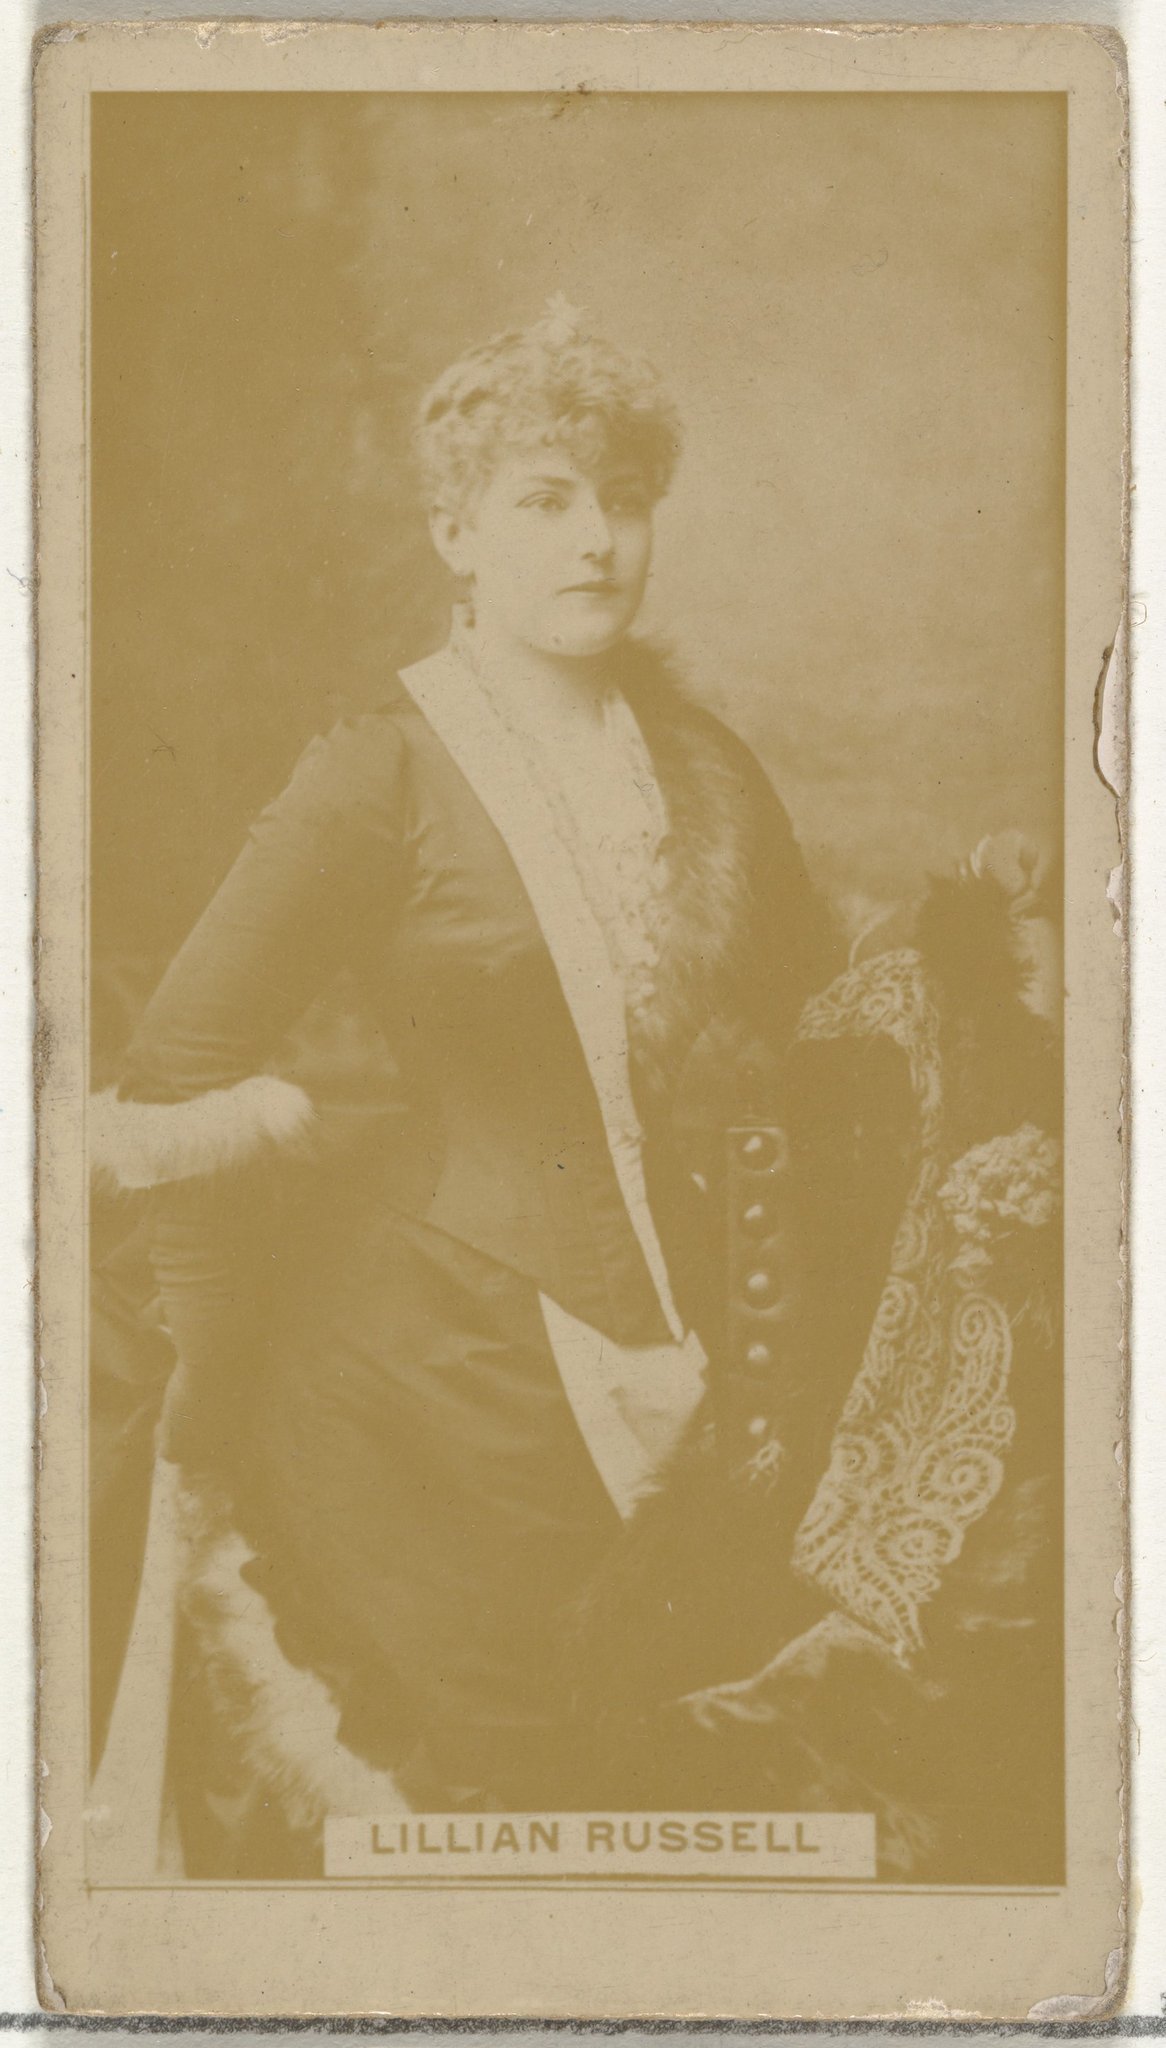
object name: photograph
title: Lillian Russell, from the Actors and Actresses series (N145-8) issued by Duke Sons & Co. to promote Duke Cigarettes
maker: w. duke, sons & co.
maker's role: publisher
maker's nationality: american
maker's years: 1870-1920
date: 1891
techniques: albumen silver print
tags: portraits,women,actresses